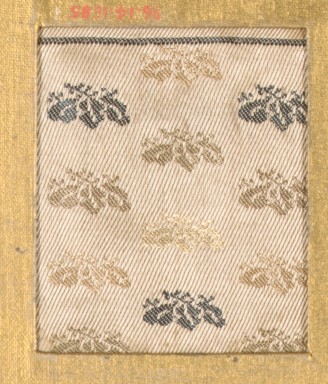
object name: piece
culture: japanese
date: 1701-1900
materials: silk